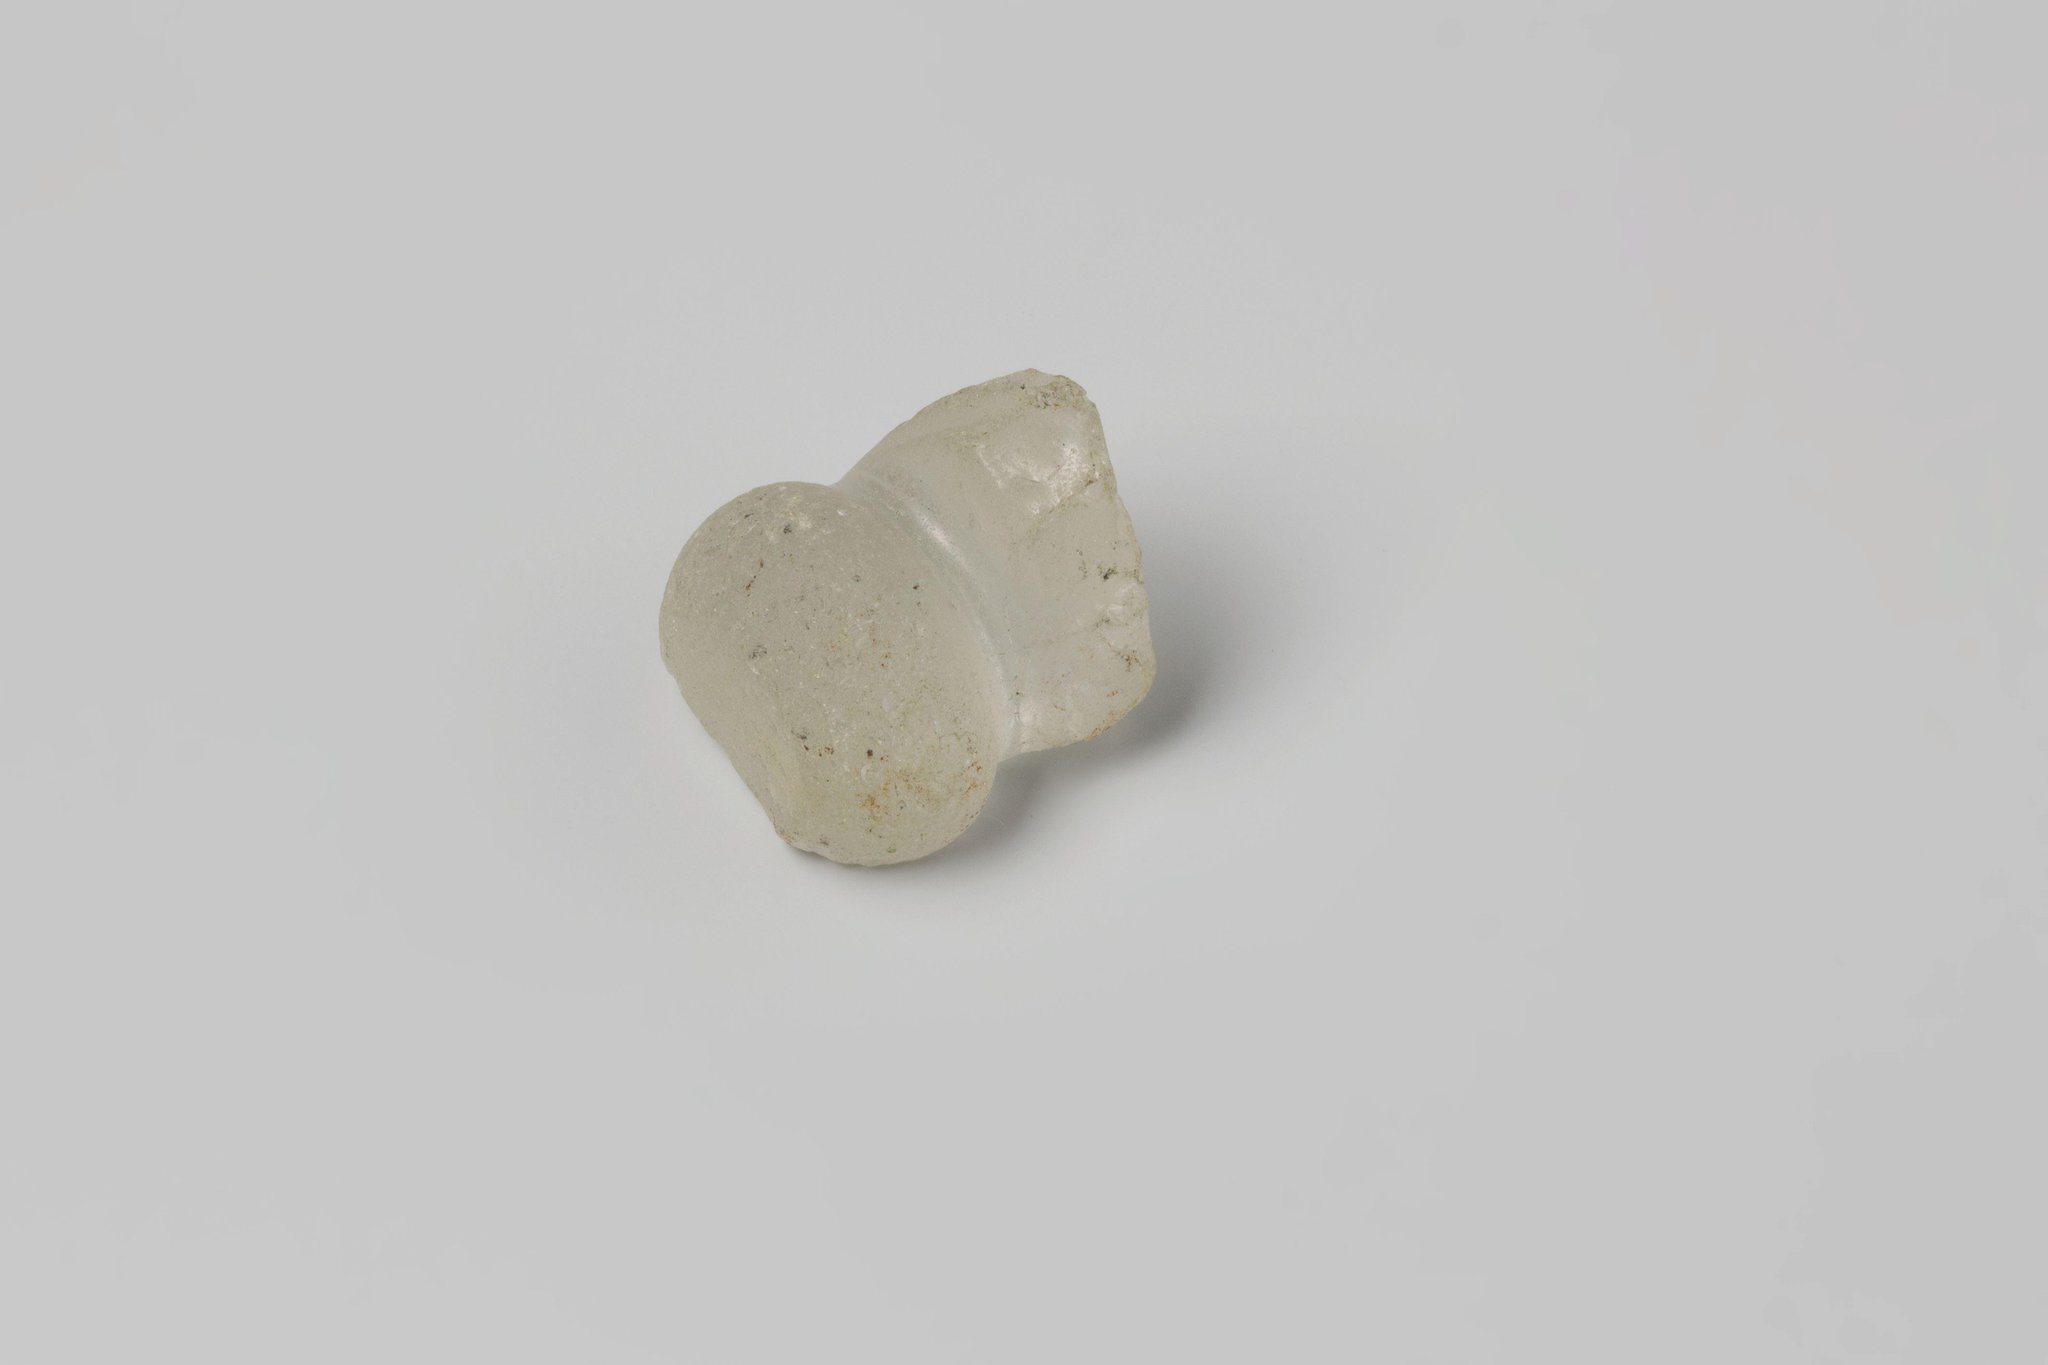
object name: helve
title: Fragment balustervormige steel van een fluitglas uit het wrak van de Oost-Indiëvaarder Hollandia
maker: Anonymous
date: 1700-1743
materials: glass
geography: netherlands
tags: verenigde oostindische compagnie, hollandia (schip), annet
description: Glass, stem glass, steel, baluster-shaped; fragment of knop, flattened, below base of bowl, both ends broken off.